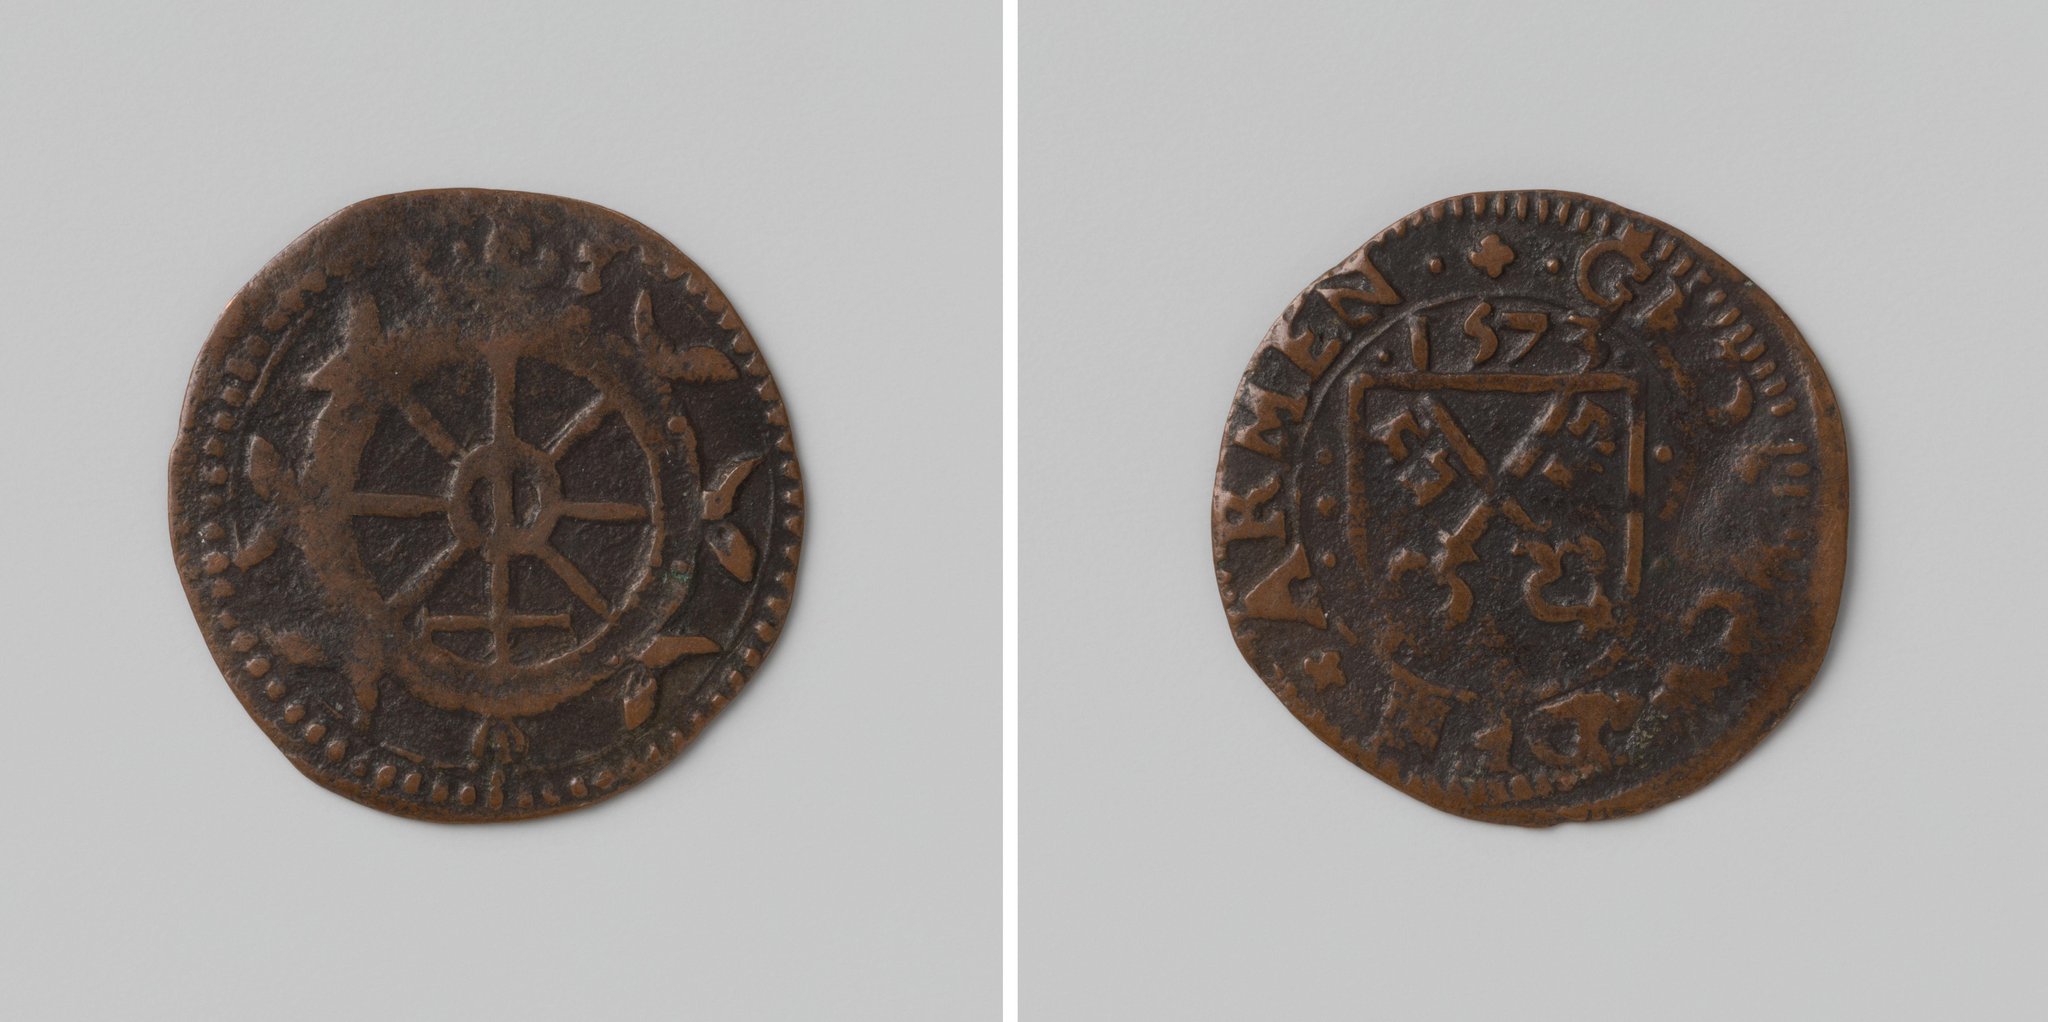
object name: oord, oortje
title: Catharina-gasthuis van Leiden, armenpenning ter waarde van een oord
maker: Anonymous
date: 1573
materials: copper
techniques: striking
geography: leiden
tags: leiden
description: Koperen penning. Voorzijde: gekroond rad. Keerzijde: wapenschild onder jaartal binnen omschrift.